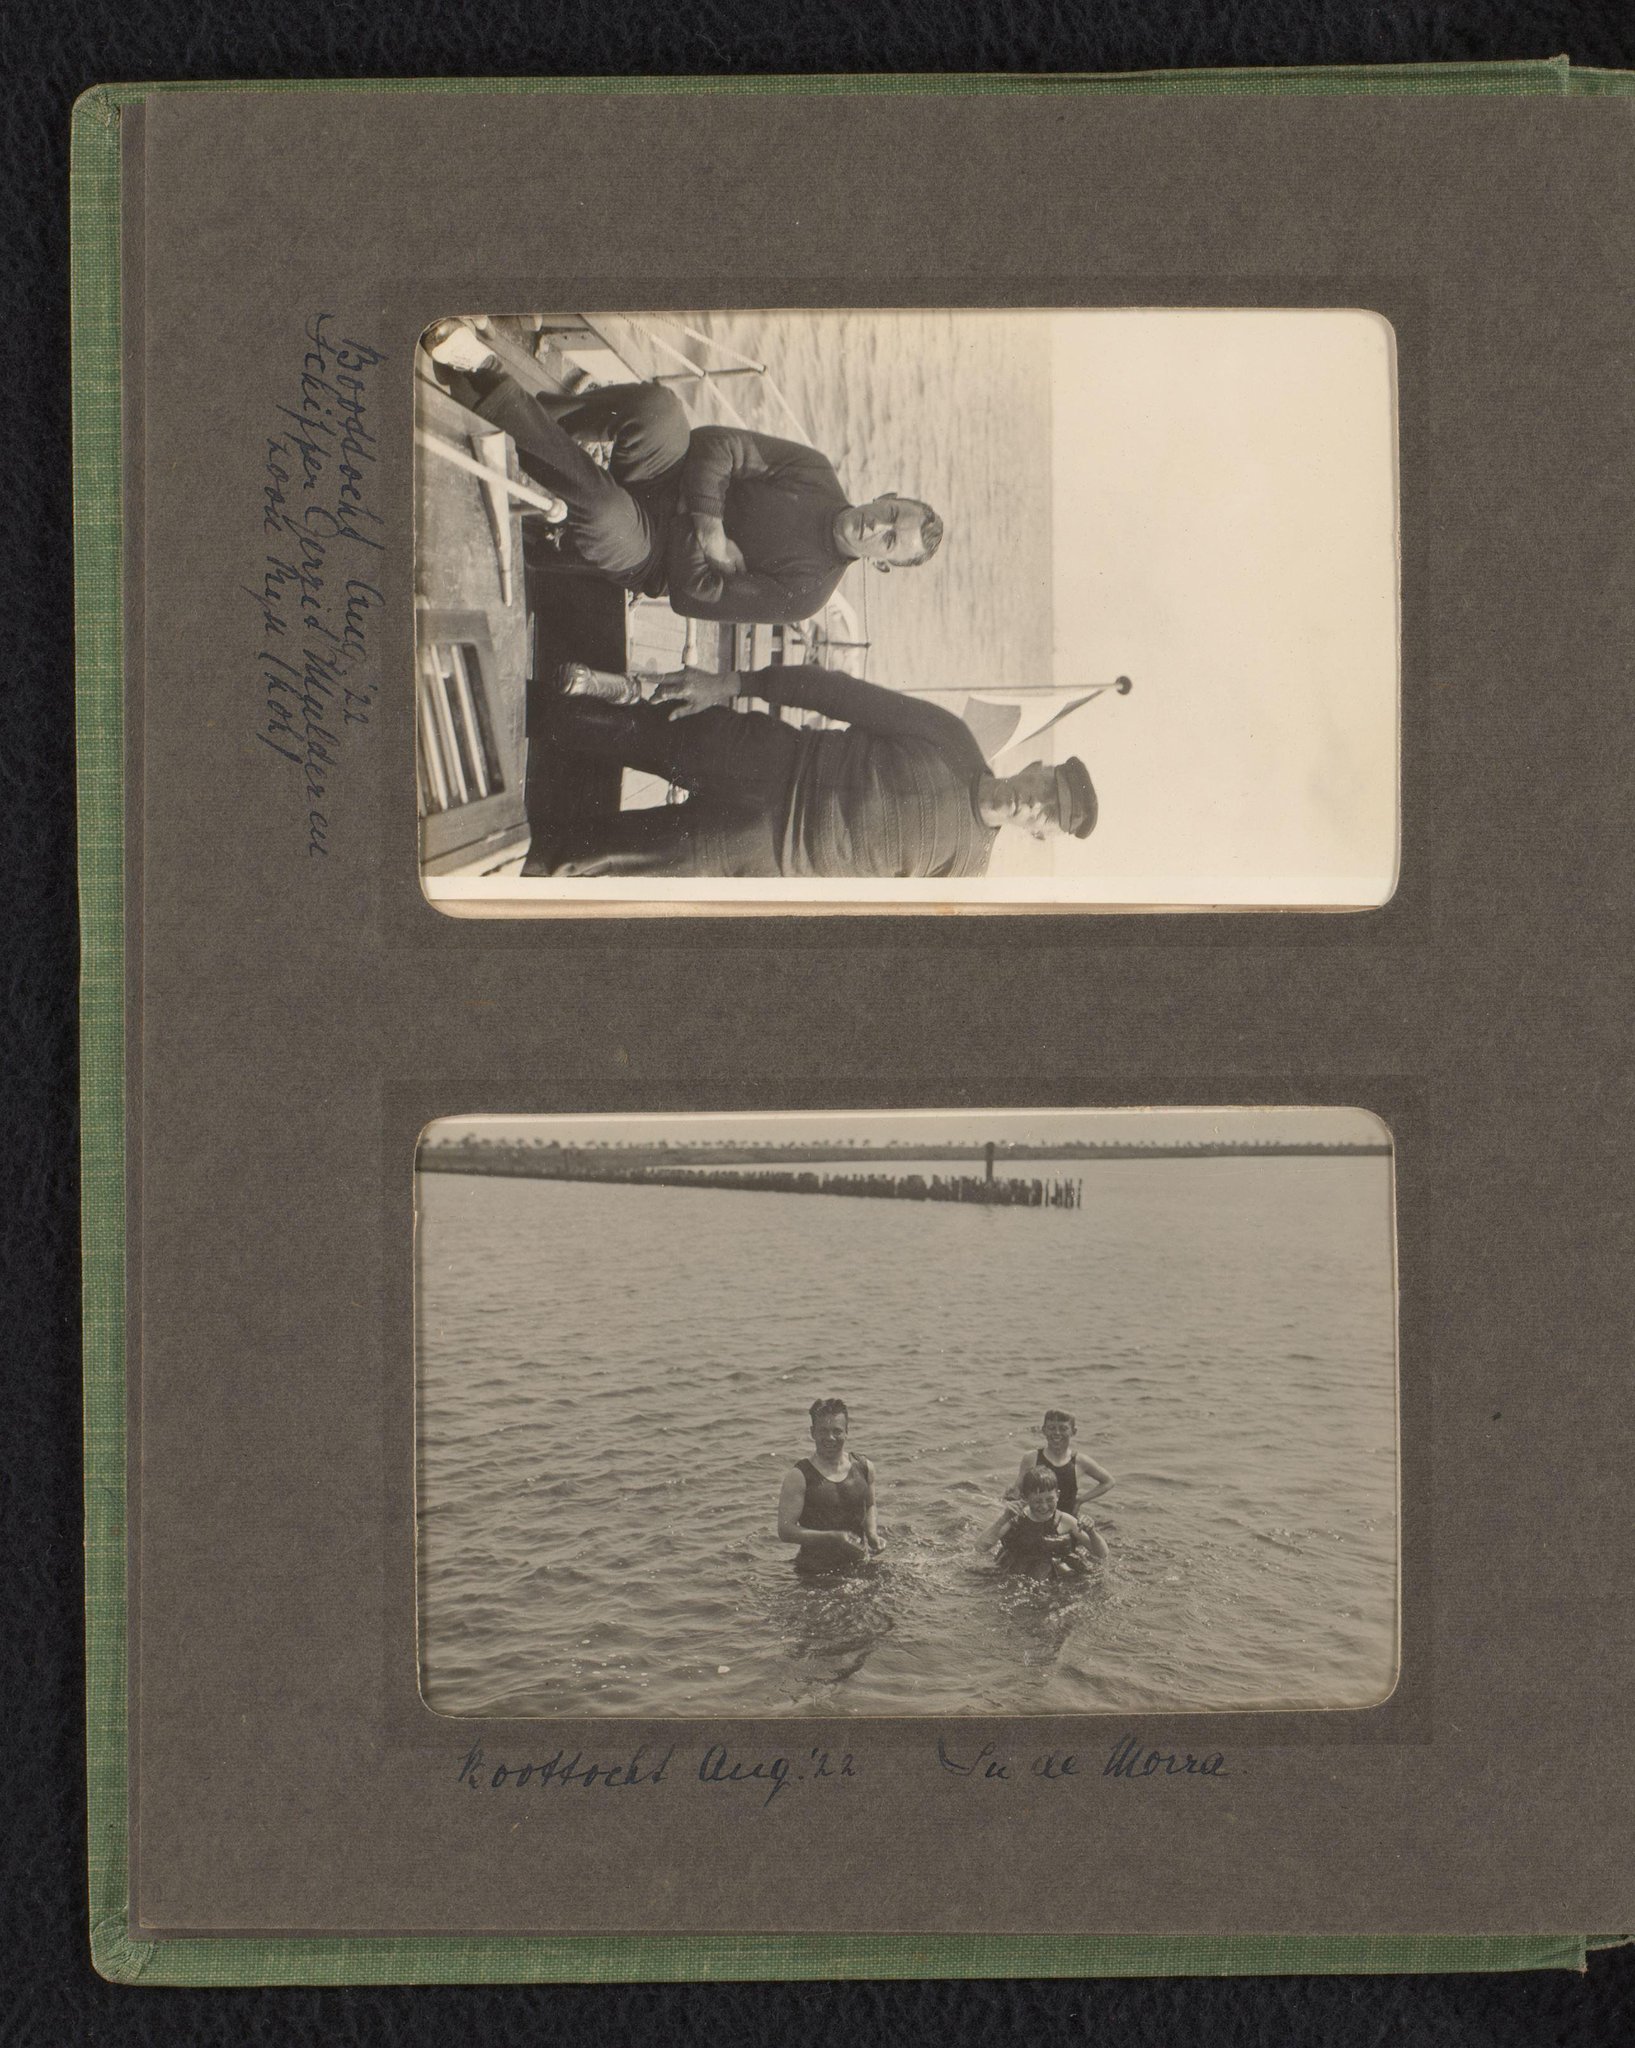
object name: album leaf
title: Twee foto's van een boottocht en zwemmers, augustus 1922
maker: hendrik herman van den berg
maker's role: amateurfotograaf, jurist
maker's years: 1875-1944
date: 1908-1922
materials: paper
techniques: gelatin silver print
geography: friesland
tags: crew ~ ship, swimming (movement in water)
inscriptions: inscription: ‘Boottocht Aug. '22/ Schipper Gerrit Mulder en/ zoon Rijk (kok)’, inscription: ‘Boottocht Aug. '22 In de Morra’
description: Deze foto's maken deel uit van een album.